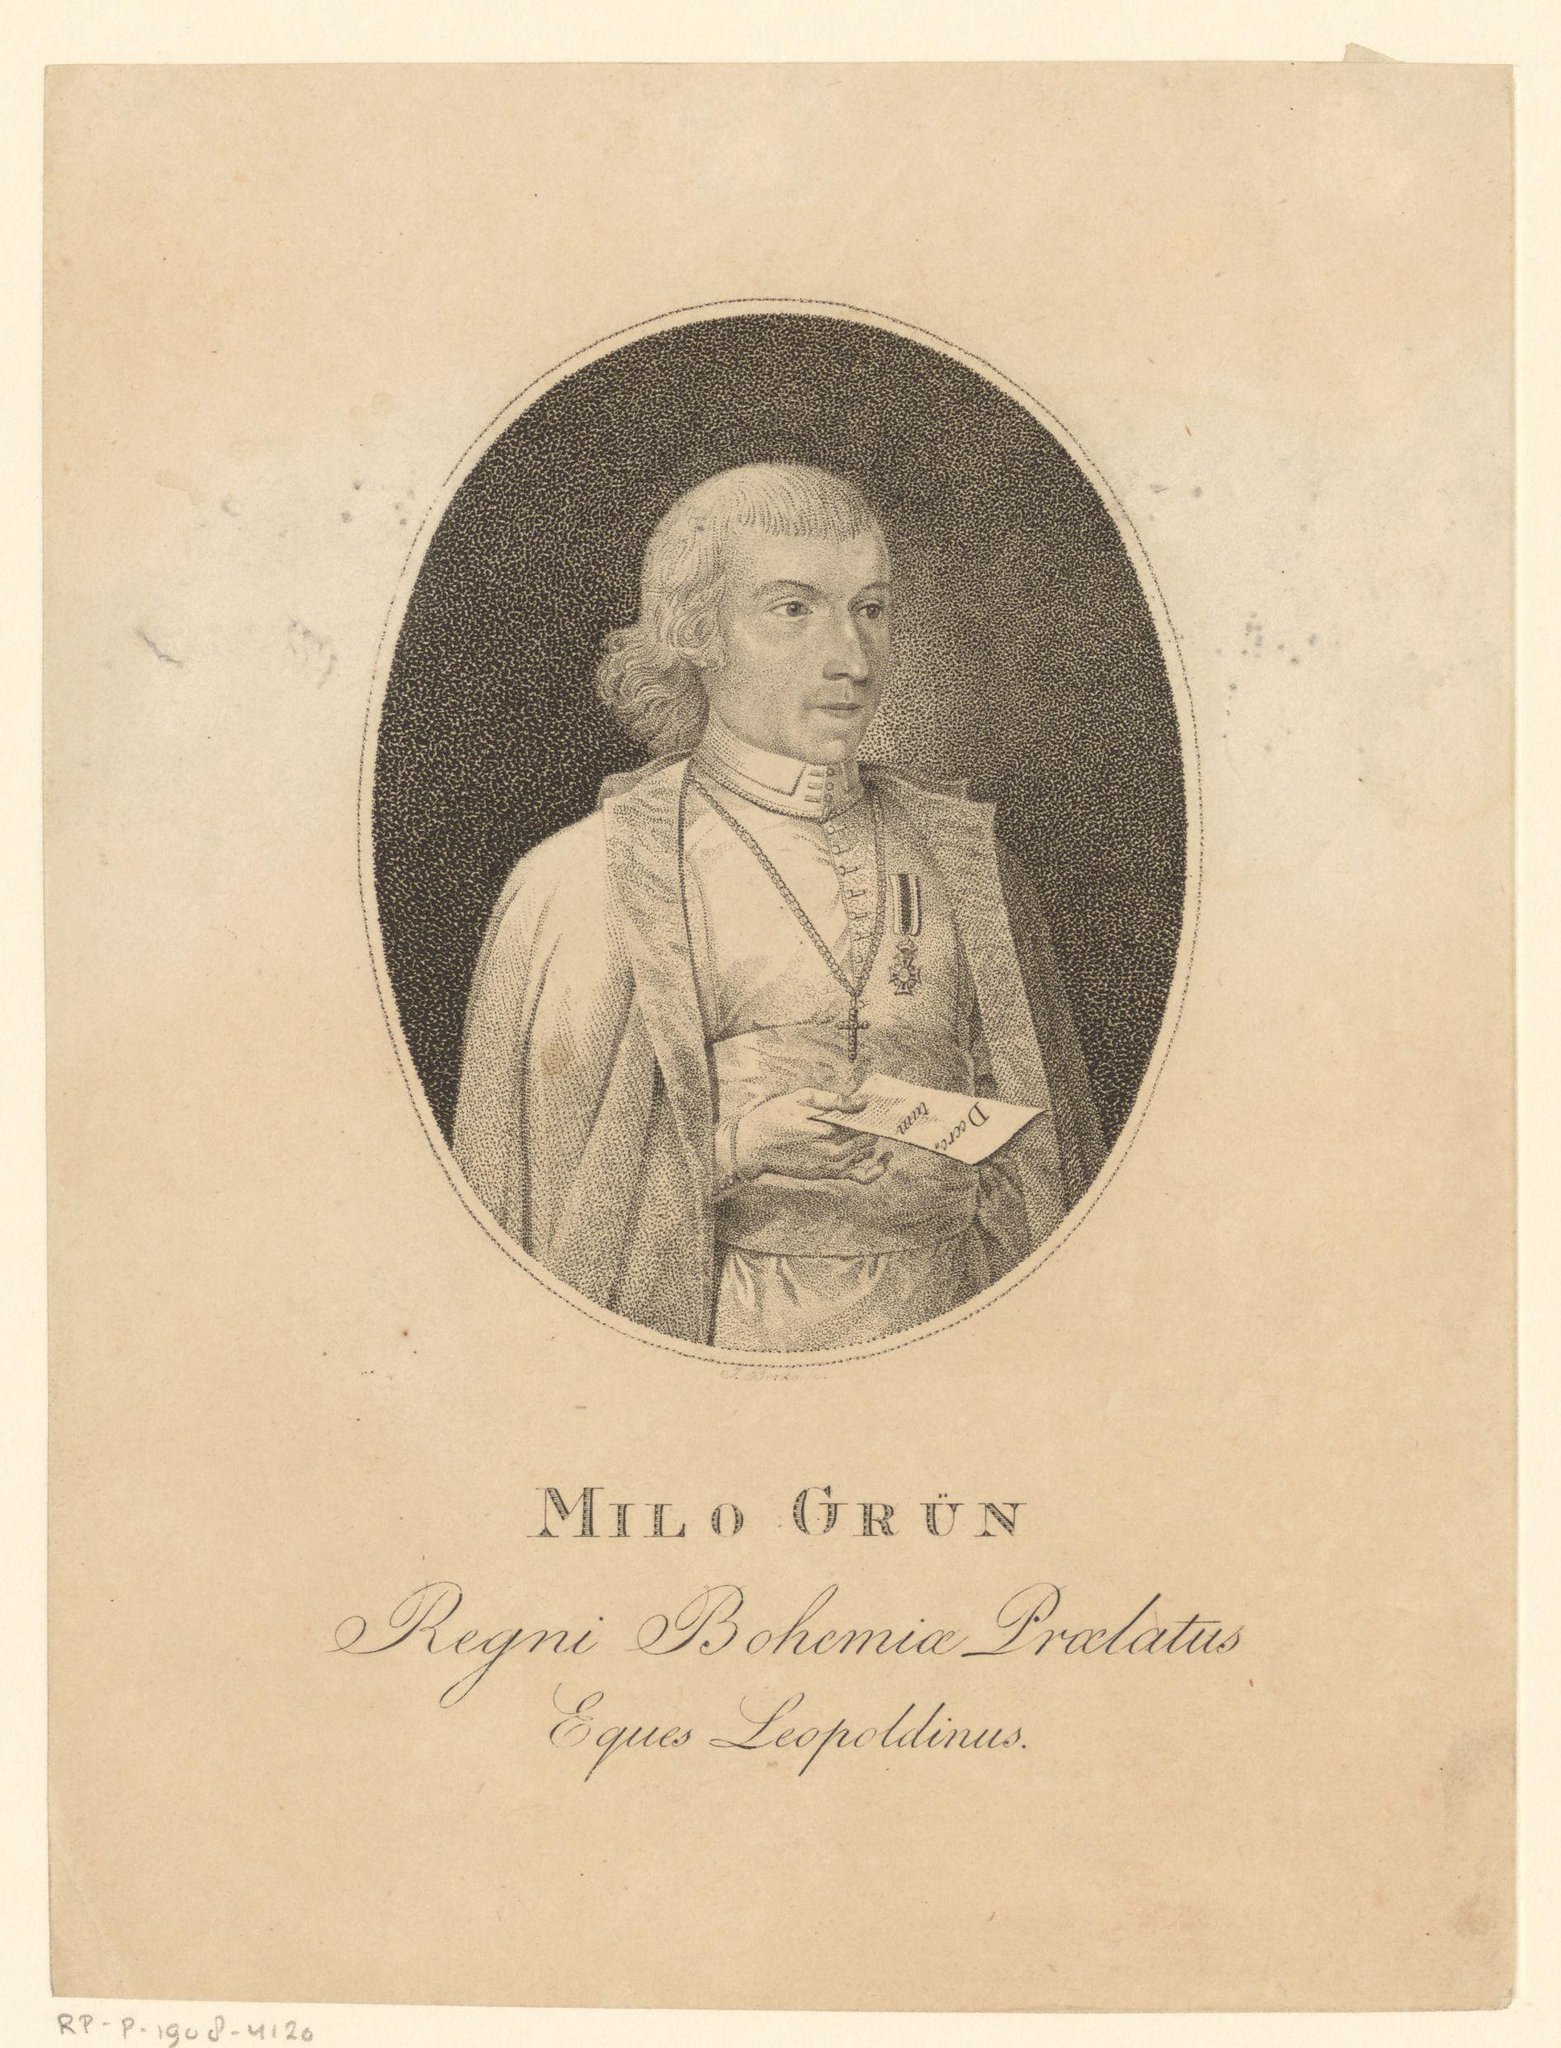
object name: print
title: Portret van Johann Nepomuk Grün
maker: johann berka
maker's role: painter, print maker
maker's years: 1759-1838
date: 1804-1838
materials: paper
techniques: stippling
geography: prague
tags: prague, historical persons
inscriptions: collector's mark: Lugt 2228